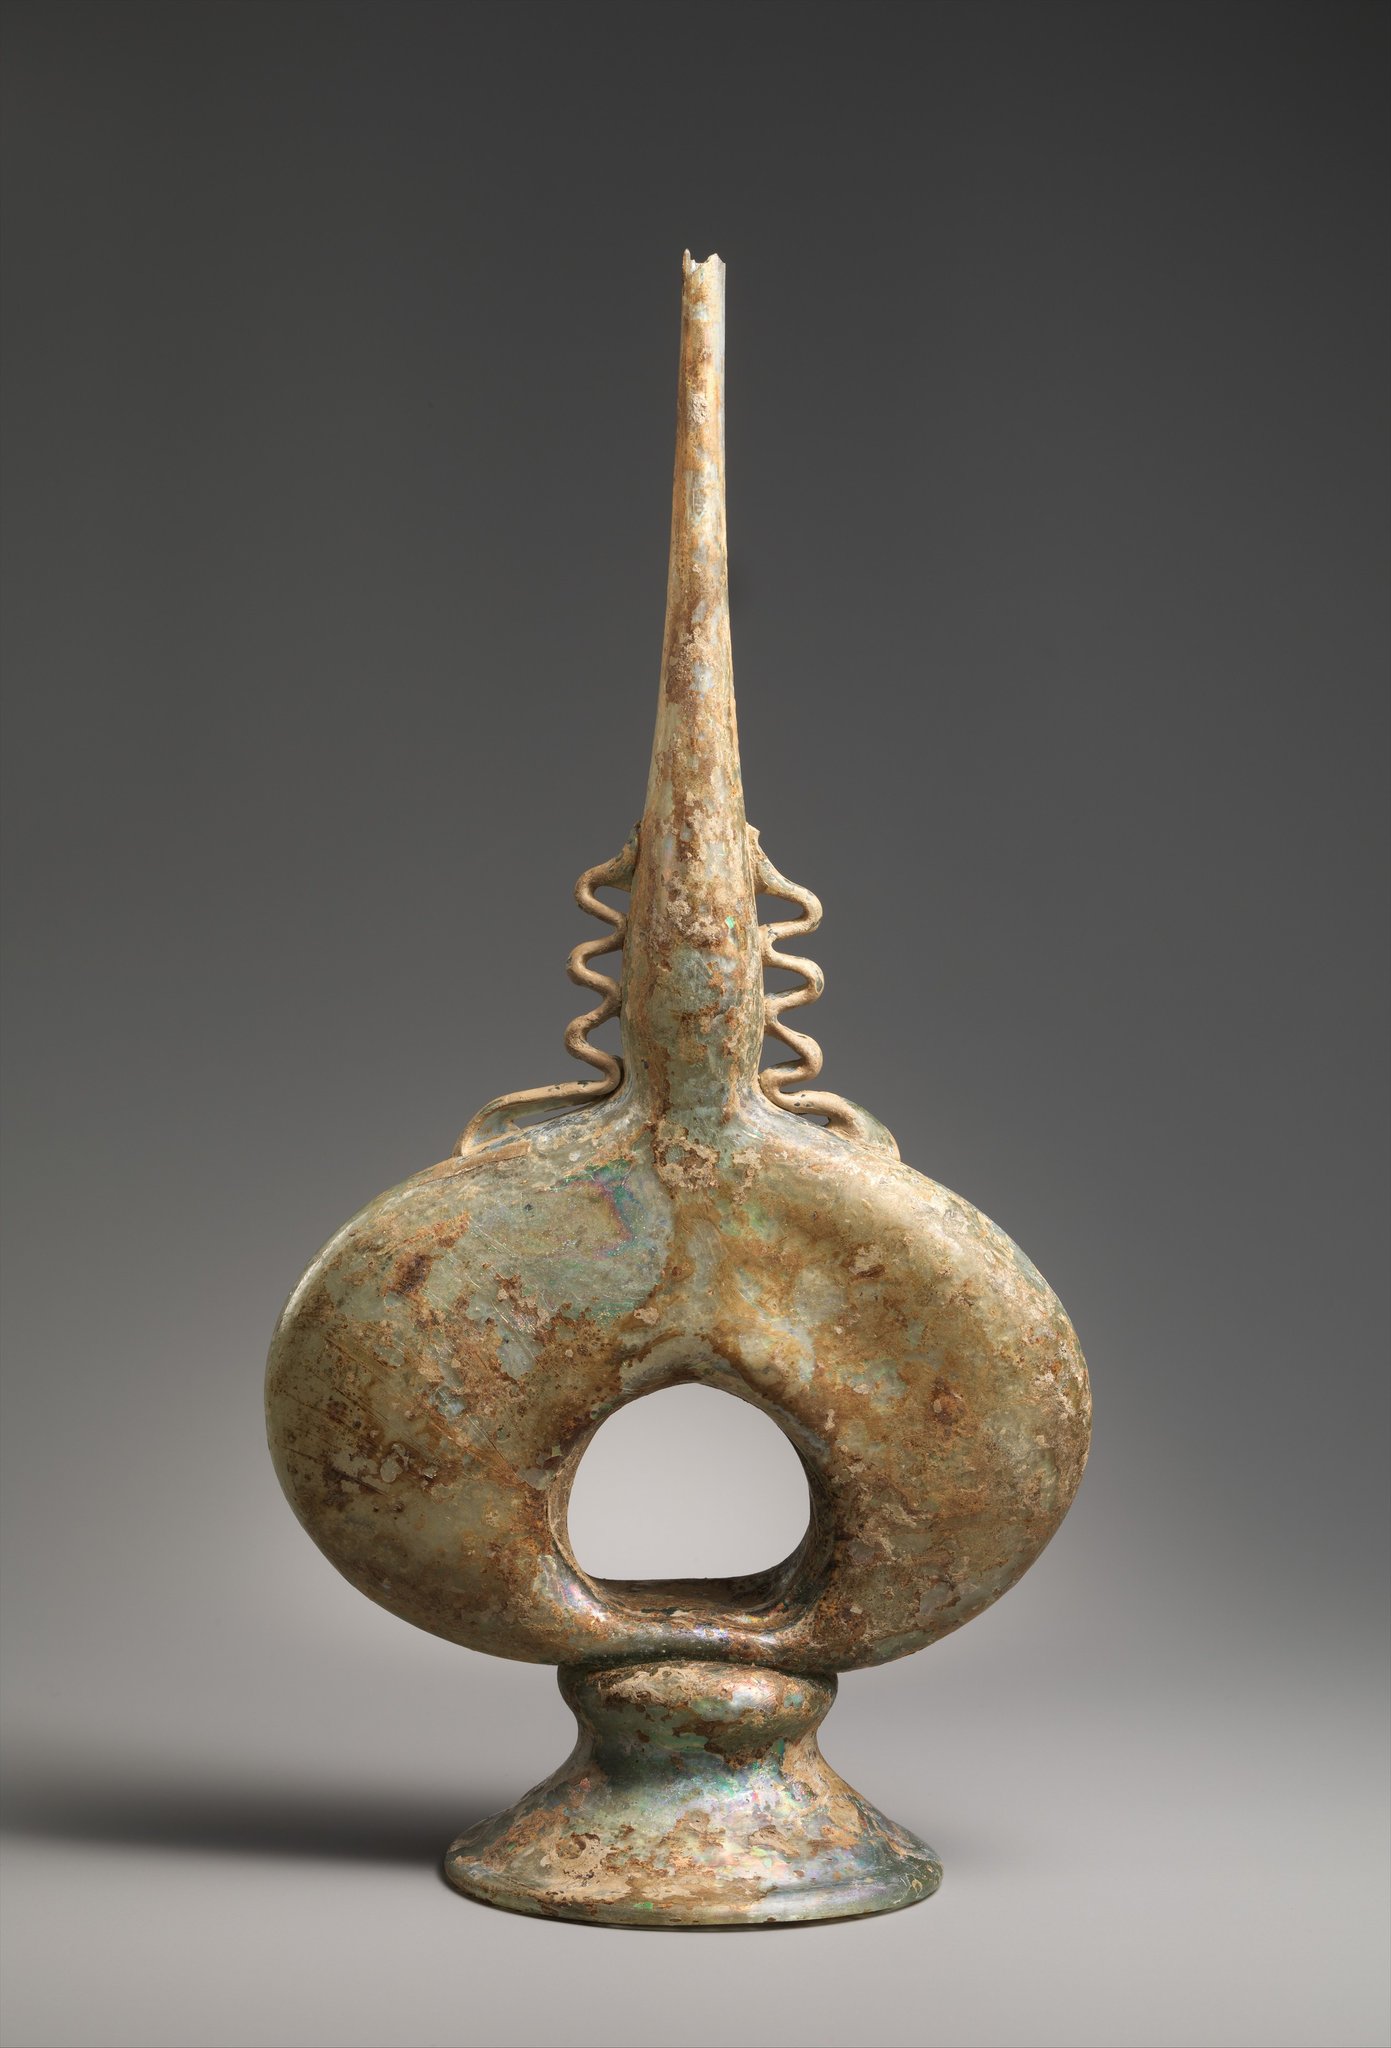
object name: perfume sprinkler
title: Perfume Sprinkler (Qumqum)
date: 1001-1266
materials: glass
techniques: glassblowing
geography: syria